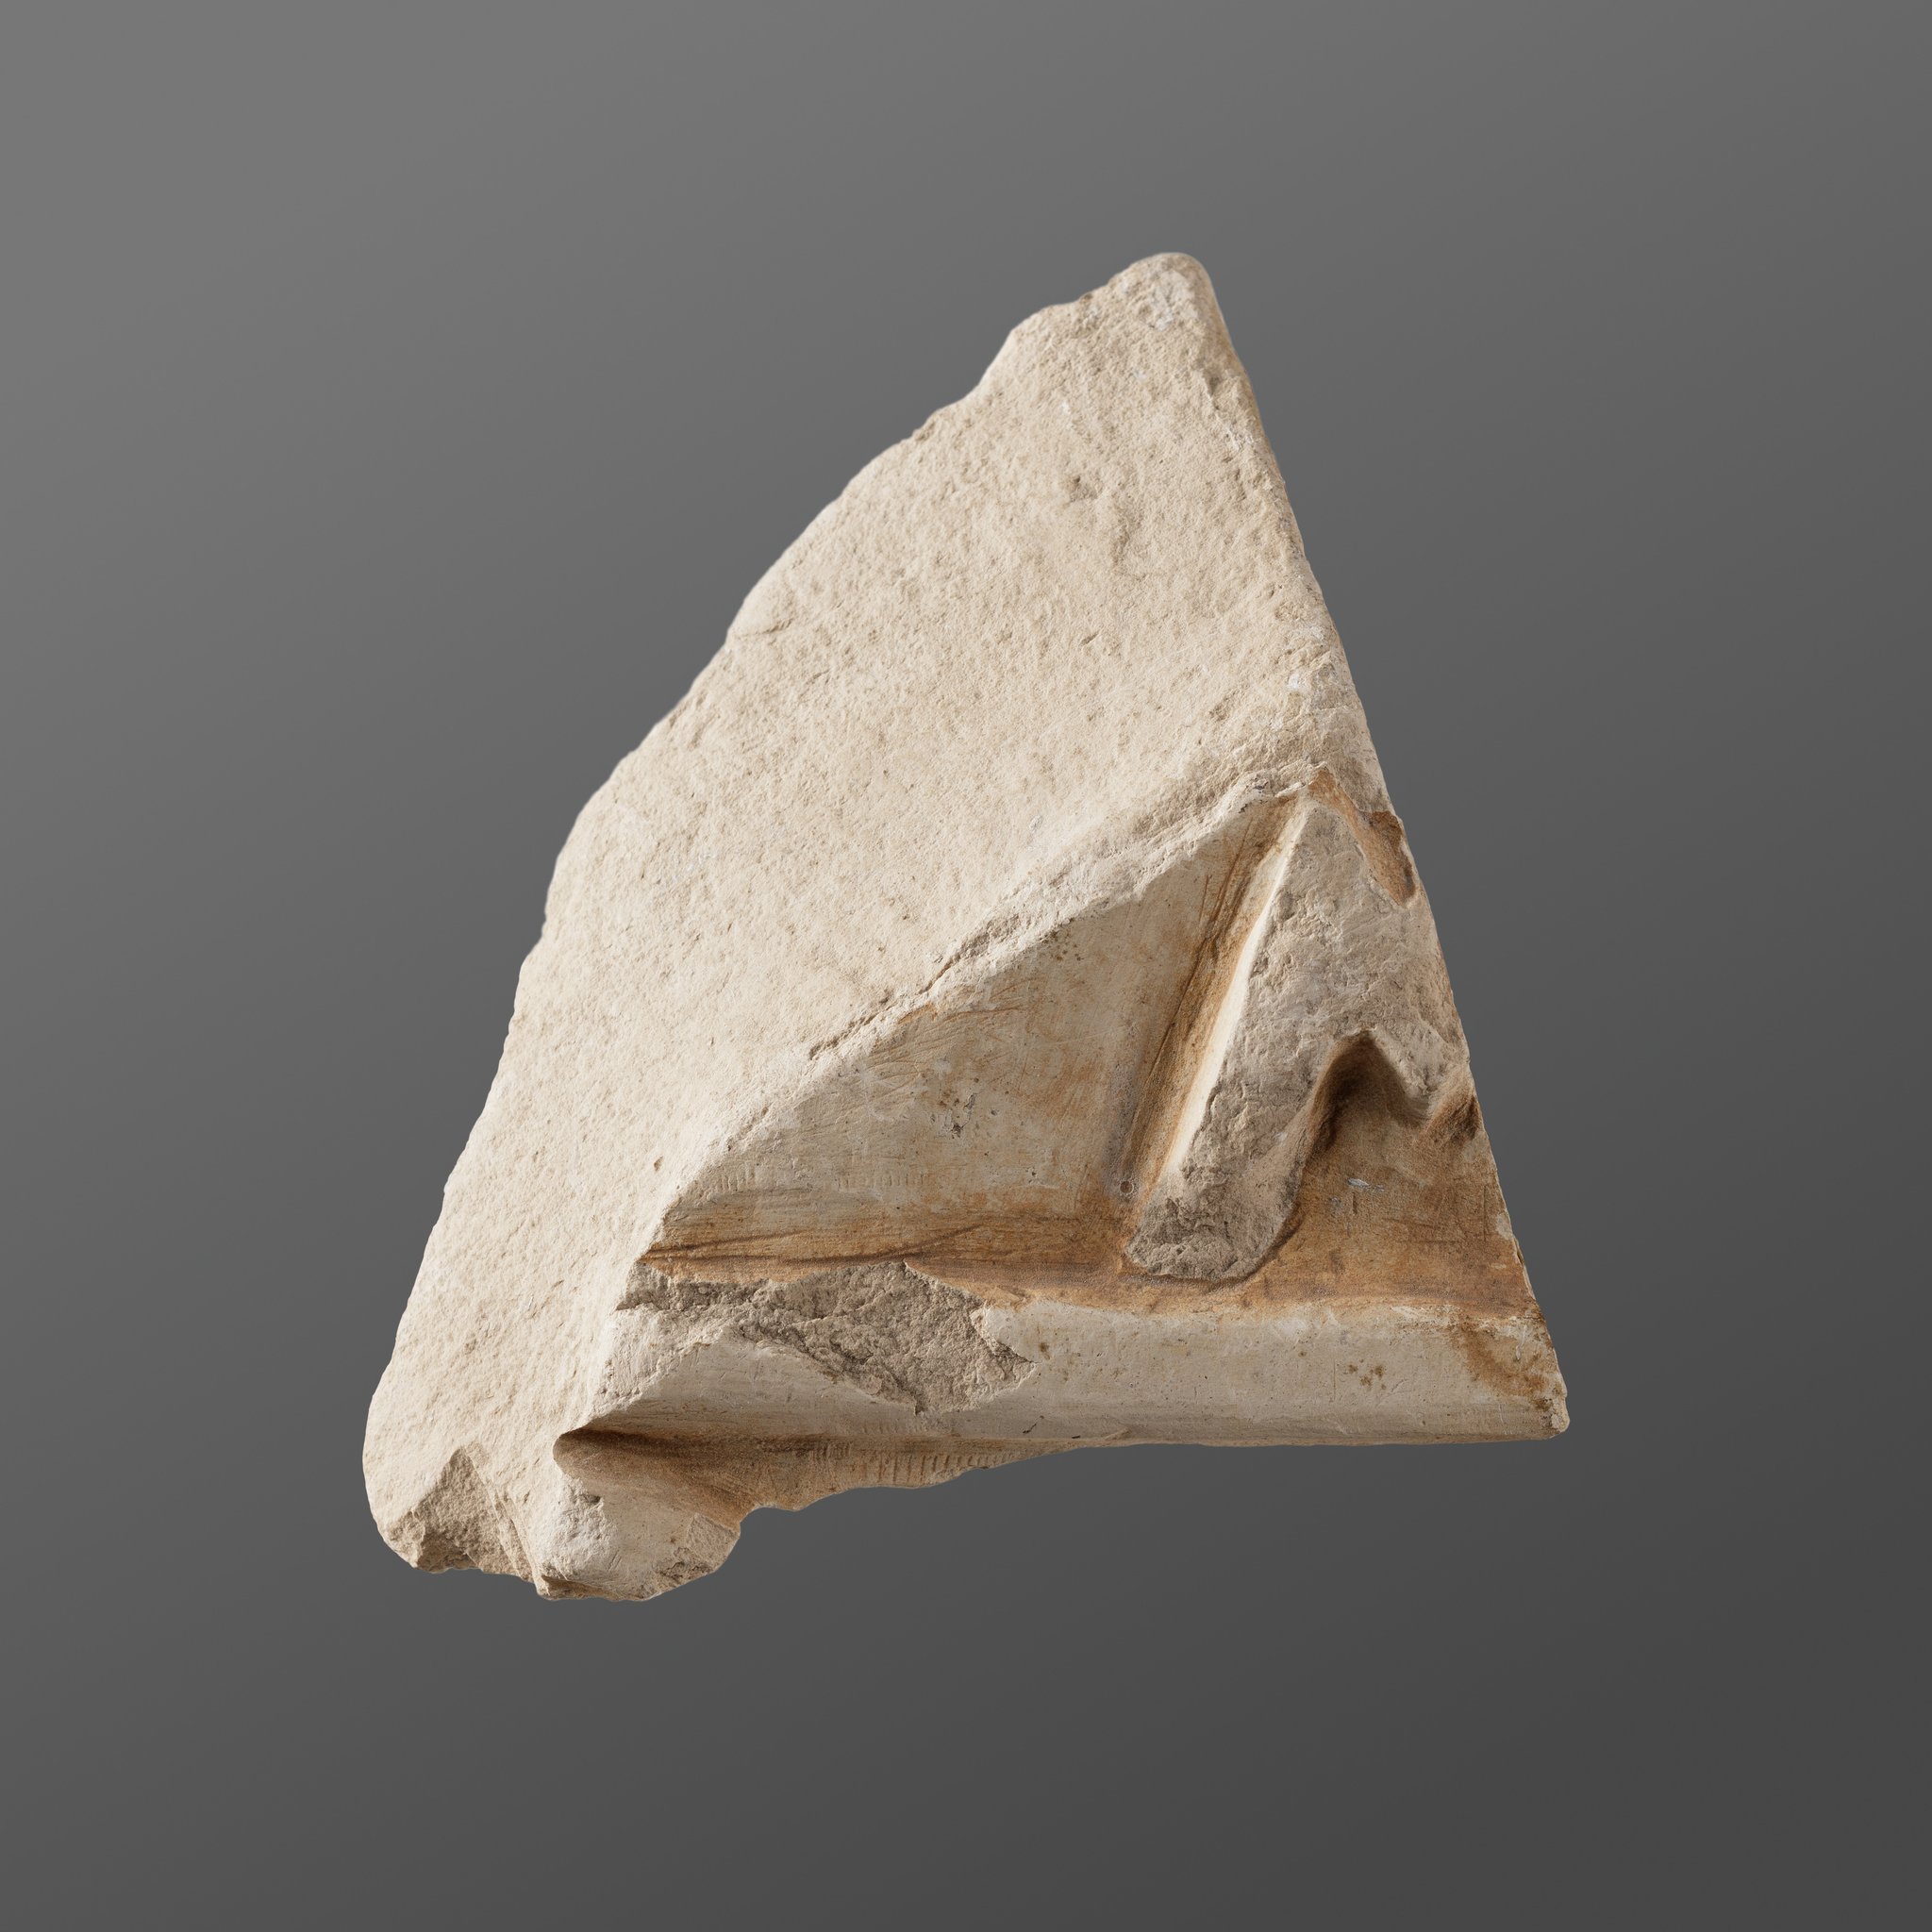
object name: relief fragment 41, tomb of mereri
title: Relief fragment possibly from the tomb of Mereri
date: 2100-2090 BCE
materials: limestone